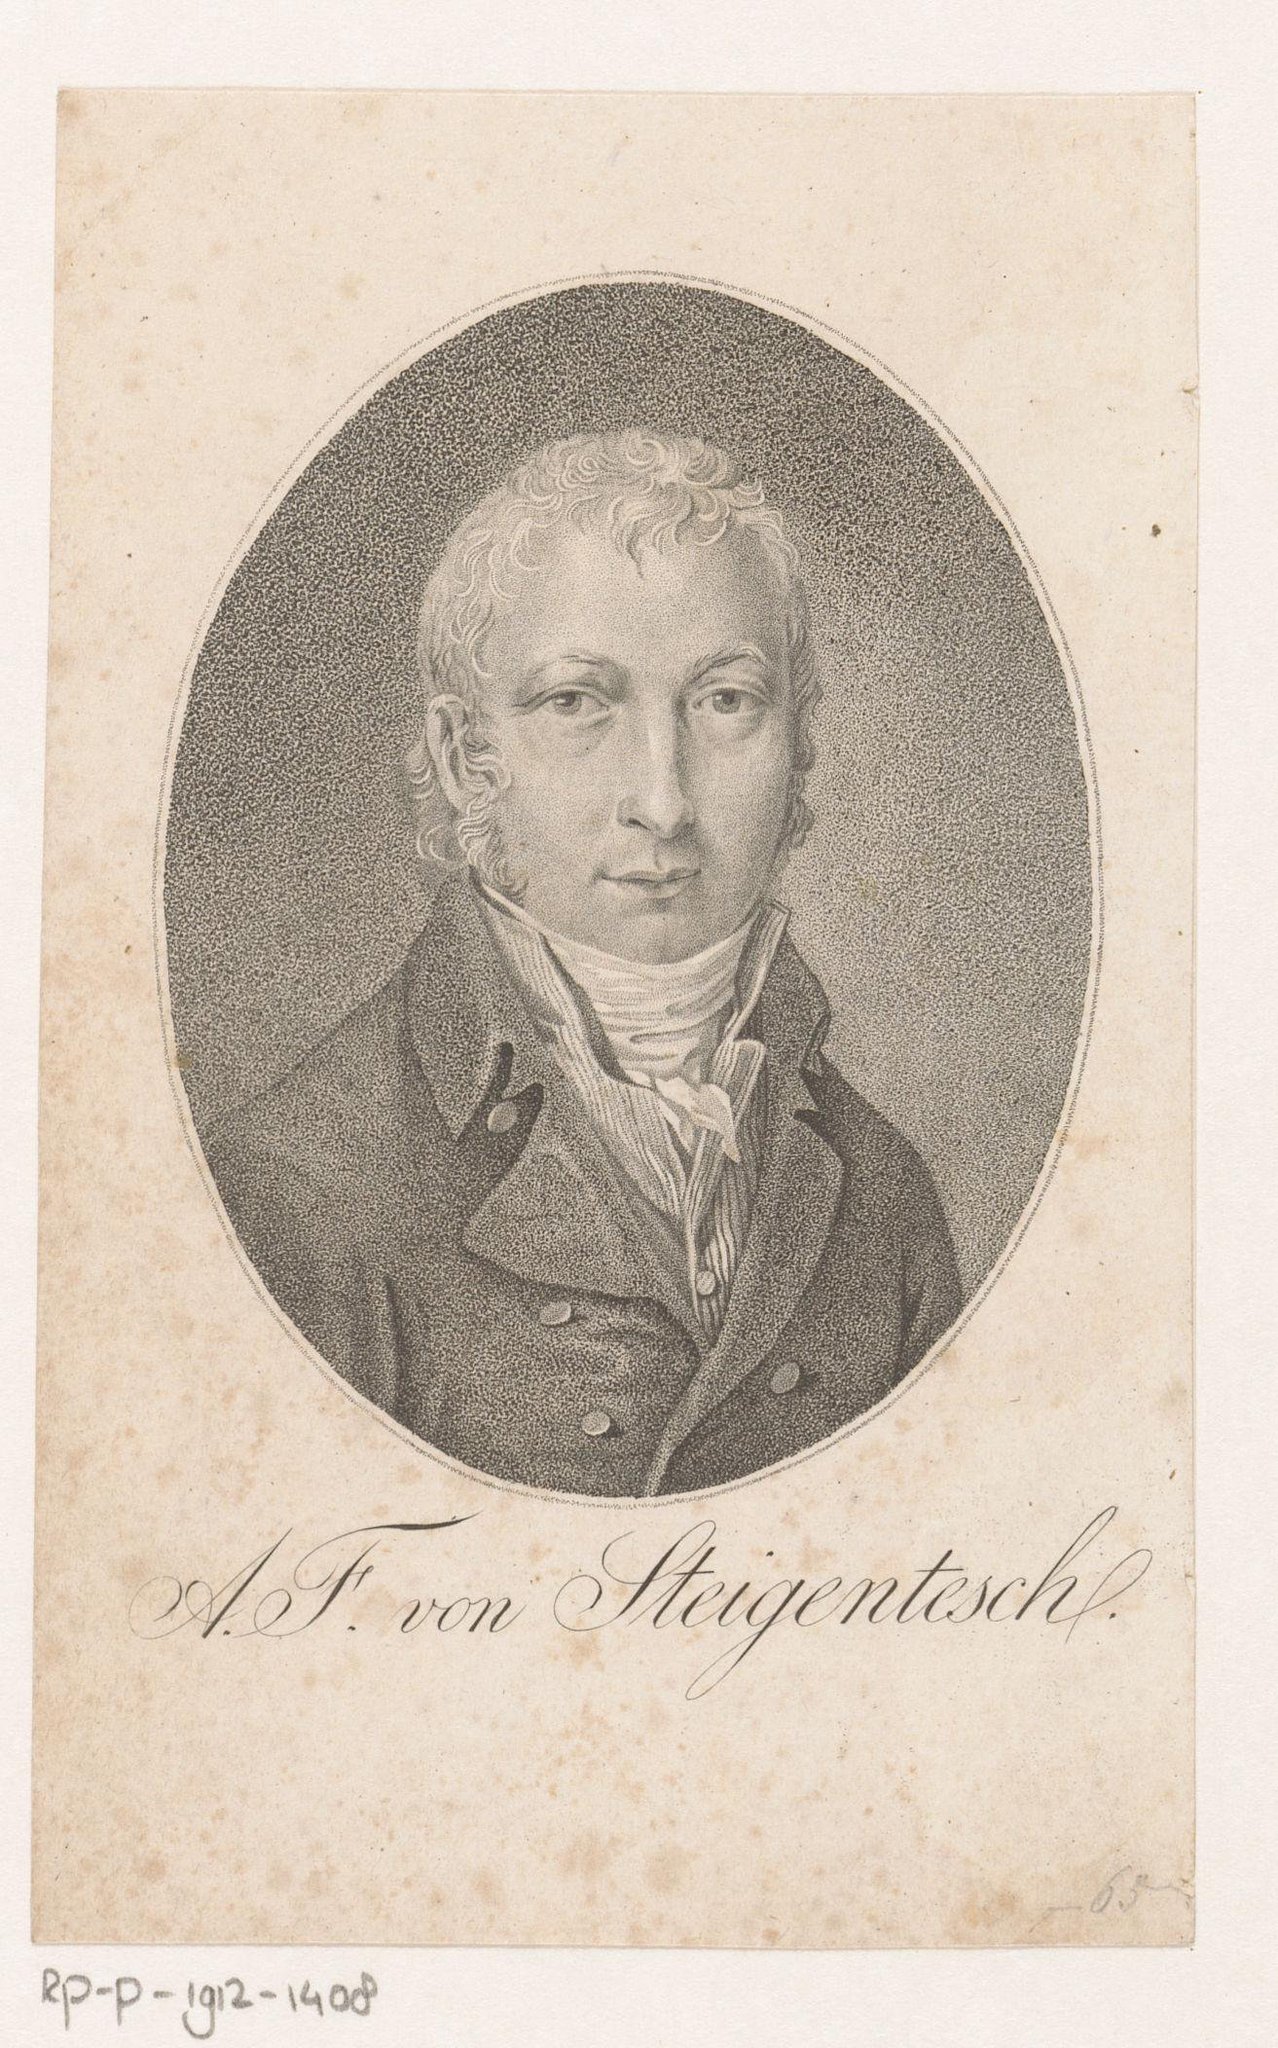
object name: print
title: Portret van August Ernst Freiherr von Steigentesch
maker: joseph franz freiherr von goez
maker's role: print maker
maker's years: 1754-1815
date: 1784-1815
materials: paper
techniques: stippling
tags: vienna, historical persons, writer, poet, author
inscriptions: collector's mark: Lugt 2228